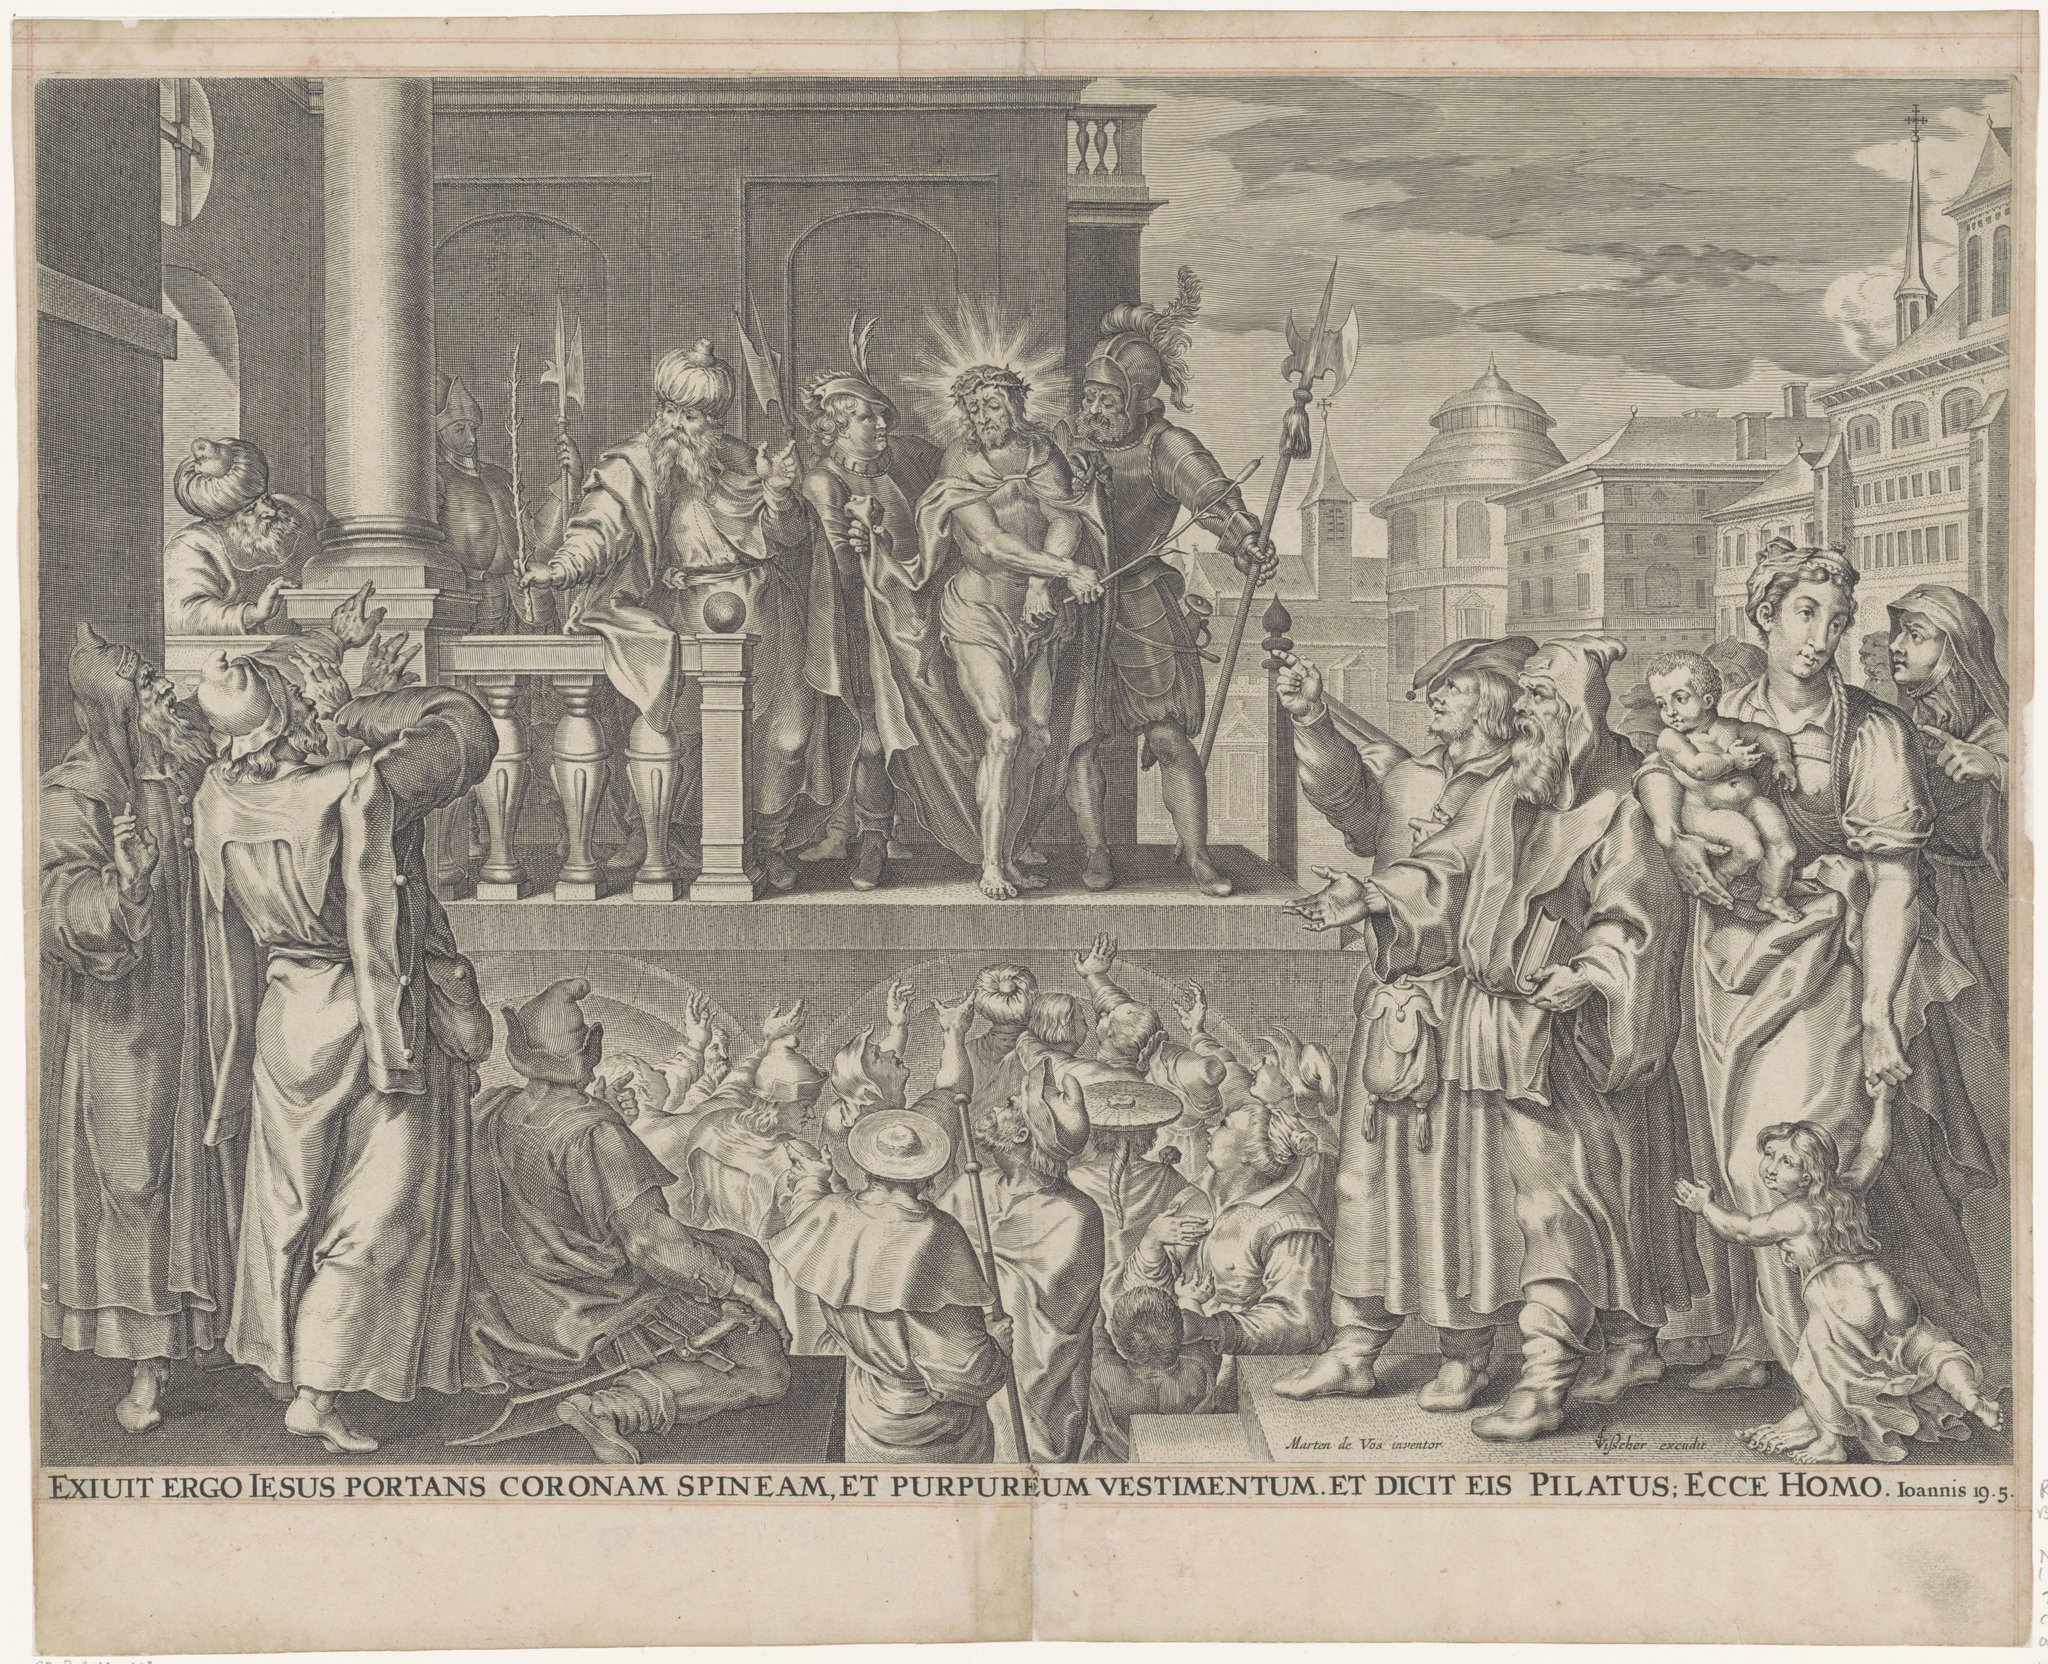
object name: print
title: Christus aan het volk getoond (Ecce Homo)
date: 1630-1652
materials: paper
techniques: engraving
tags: carrying a child on the hip, astride, crowd, mob, pilate showing christ to the people, 'ostentatio christi', 'ecce homo' (john 19:4-6)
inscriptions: collector's mark: Lugt 2228, collector's mark: Lugt 2760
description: De Amsterdamse uitgever Claes Jansz. Visscher (II) produceerde vanaf de jaren ’30 van de zeventiende eeuw grote Bijbelse prenten op zogenaamd royaal-formaat papier (ca. 480 x 580 mm). Na zijn dood in 1652 zette zijn zoon Nicolaes Visscher (I) het bedrijf voort en zo ook de uitgave van Royaalbijbelprenten. Toen Nicolaes in 1679 overleed nam zijn zoon Nicolaes Visscher (II) het bedrijf over en gaf kort hierna, omstreeks 1680, een fondslijst uit. Hierin worden 130 prenten met Bijbelse voorstellingen op royaalpapier beschreven (zie documentatie J. van der Waals). Complete prentbijbels op royaal-formaat werden door vader en zoon Nicolaes Visscher uitgegeven onder de titel Historiae Sacrae Veteris et Novi Testamenti. De bladen werden echter ook los verkocht en konden worden gecombineerd met Royaalbijbel-prenten van andere uitgevers. Verschillende Amsterdamse uitgevers brachten namelijk ook bijbelprenten op royaal-formaat uit, onder wie Clement de Jonghe en Cornelis Danckerts. De door de firma Visscher uitgegeven prenten zijn veelal vervaardigd door anonieme prentmakers naar voorbeeld van verschillende zestiende- en zeventiende-eeuwse Bijbelse prenten en prentreeksen. Veelal moesten de composities worden aangepast aan het grotere en langgerekte royaal-formaat. Daarnaast zijn er ook grote bladen van bekende prentmakers zoals Jan van Londerseel, Pieter Nolpe, Jacques de Gheyn (II) en Jan Harmensz. Muller opgenomen in de categorie ‘Bybelsche Figuren, op Royaal-bladen’ in de fondslijst van Visscher. Prent mogelijk gebruikt in: Historiae Sacrae Veteris et Novi Testamenti (Royaalbijbel). Amsterdam: Nicolaes Visscher (I) en (II), [1652-1702]. In de fondslijst van Nicolaes Visscher II (ca. 1680) is het onderwerp van deze prent onder de titel 'Bybelsche Figuren, op Royaal-bladen. bestaande uyt de volgende historien.' als volgt genummerd: 113.